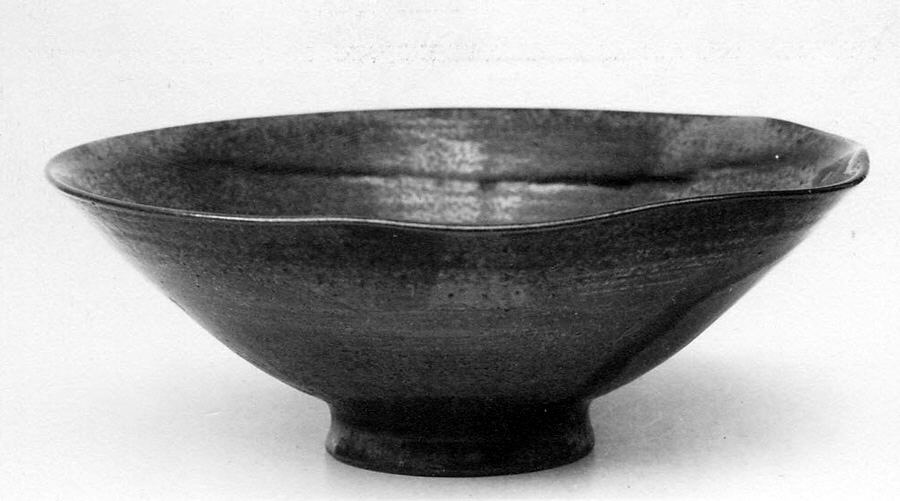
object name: teabowl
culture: japanese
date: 1780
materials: clay, glaze